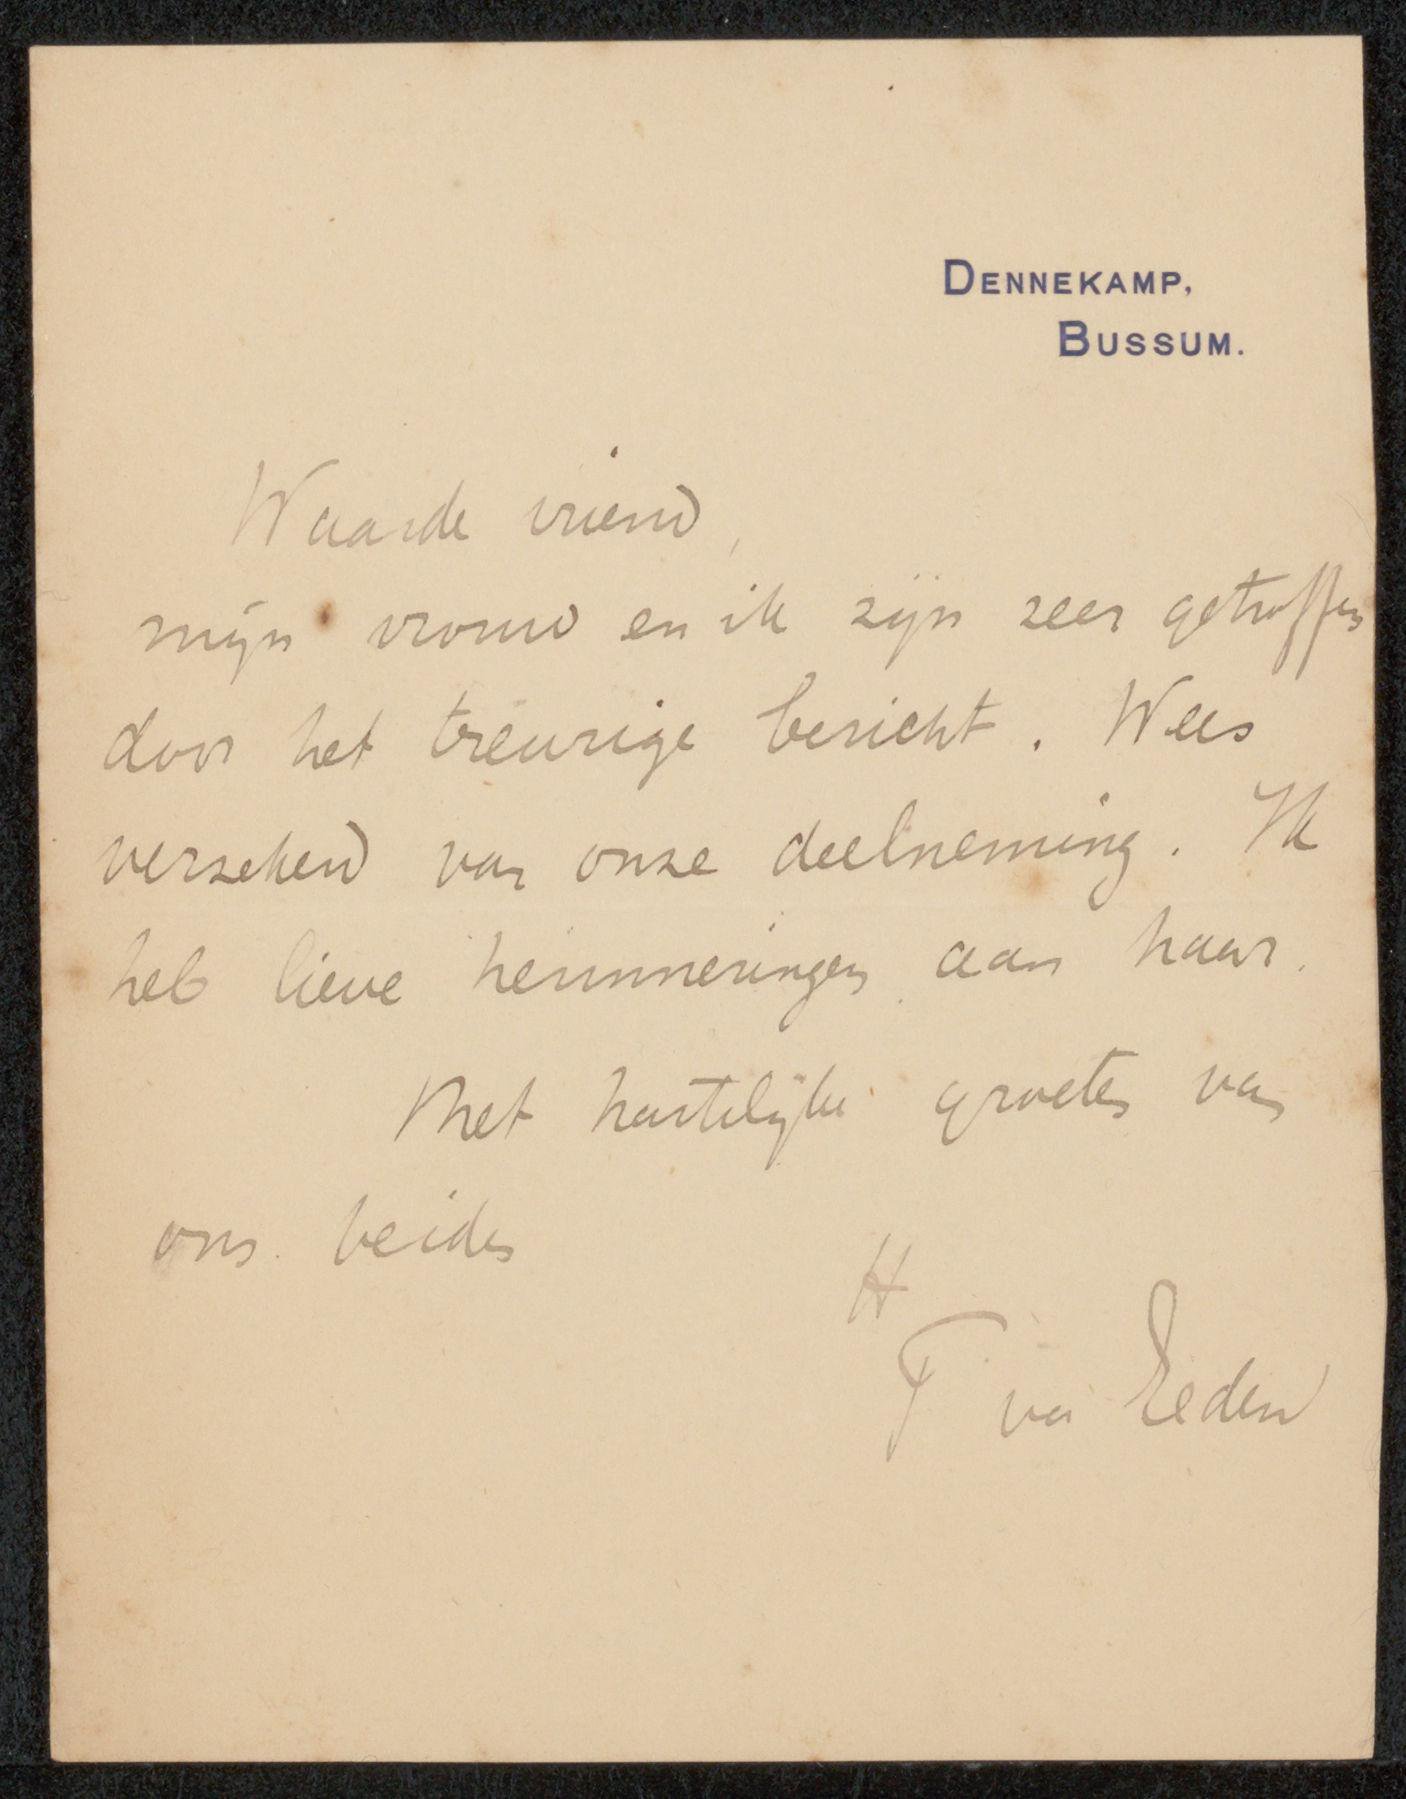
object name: letter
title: Brief aan Philip Zilcken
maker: frederik van eeden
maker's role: schrijver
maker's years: 1860-1932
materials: ink, paper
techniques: pen, writing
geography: bussum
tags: brussels, helène lambertine hauzeur, painter, draughtsman, philip zilcken, passions, emotions, affections